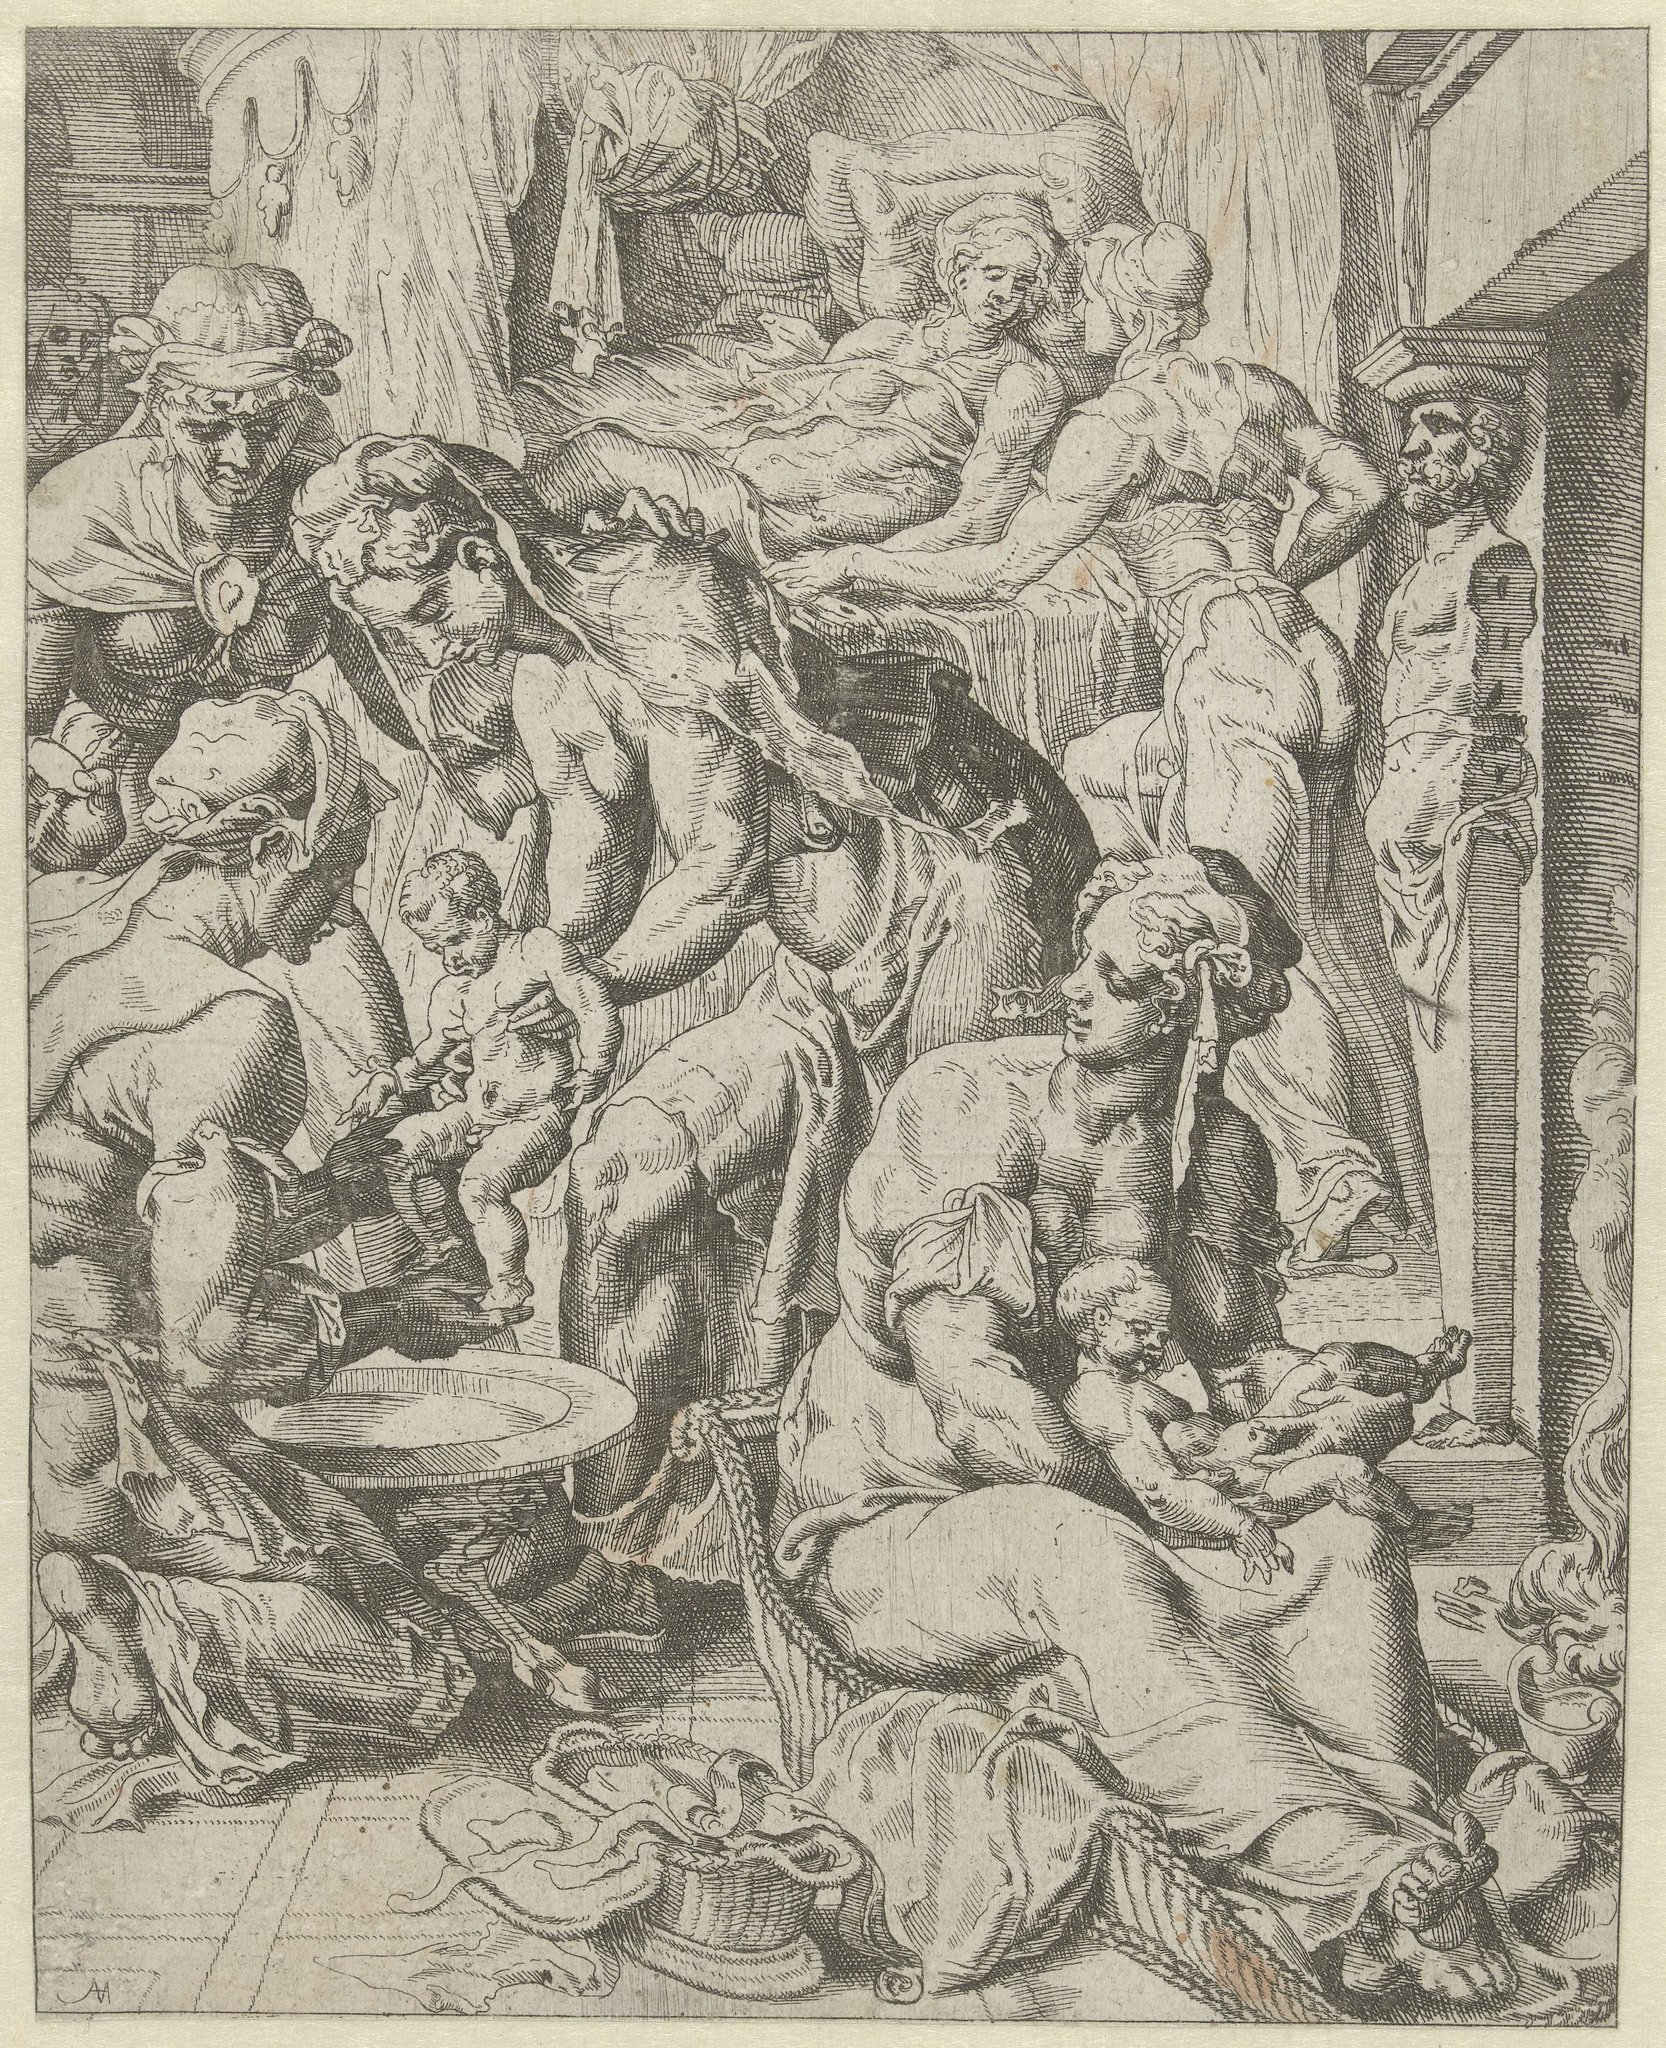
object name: print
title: Geschiedenis van Juda en Tamar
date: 1549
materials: paper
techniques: etching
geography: haarlem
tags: birth of the twins: pharez and zarah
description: Tamar ligt op het kraambed. Ze heeft net een tweeling gebaard: Peres en Zerach. De vroedvrouwen verzorgen de baby's. De prent maakt deel uit van een serie over de geschiedenis van Juda en Tamar